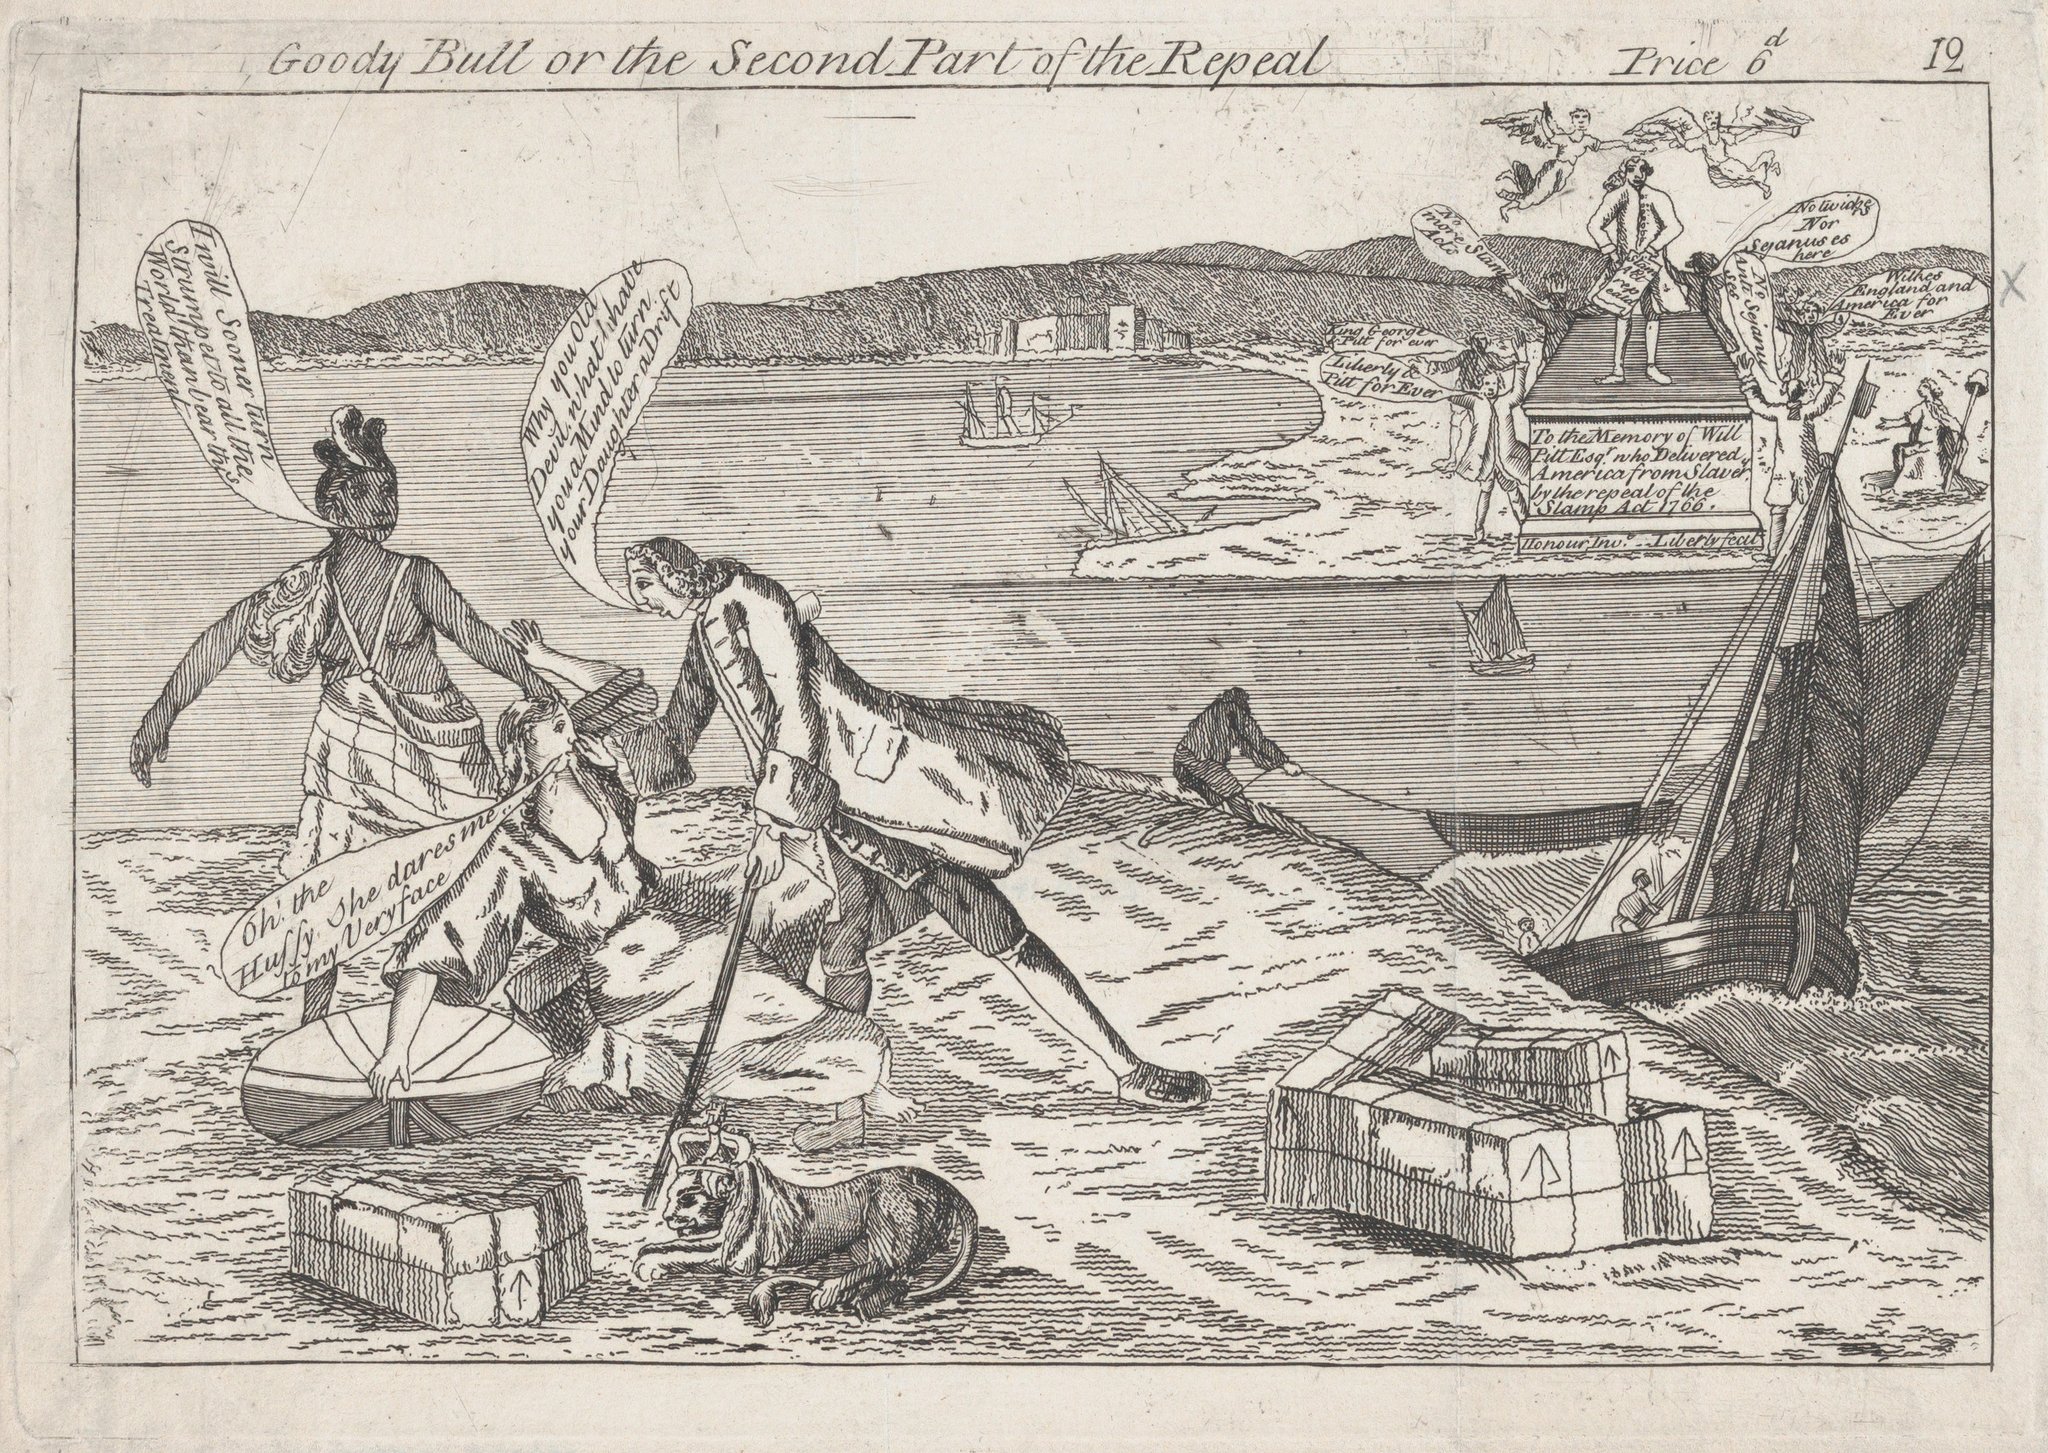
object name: print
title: Goody Bull or the Second Part of the Repeal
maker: anonymous, british, 18th century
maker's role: artist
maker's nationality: british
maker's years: 1700-1800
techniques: etching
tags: satire,american revolution,men,boats,politics